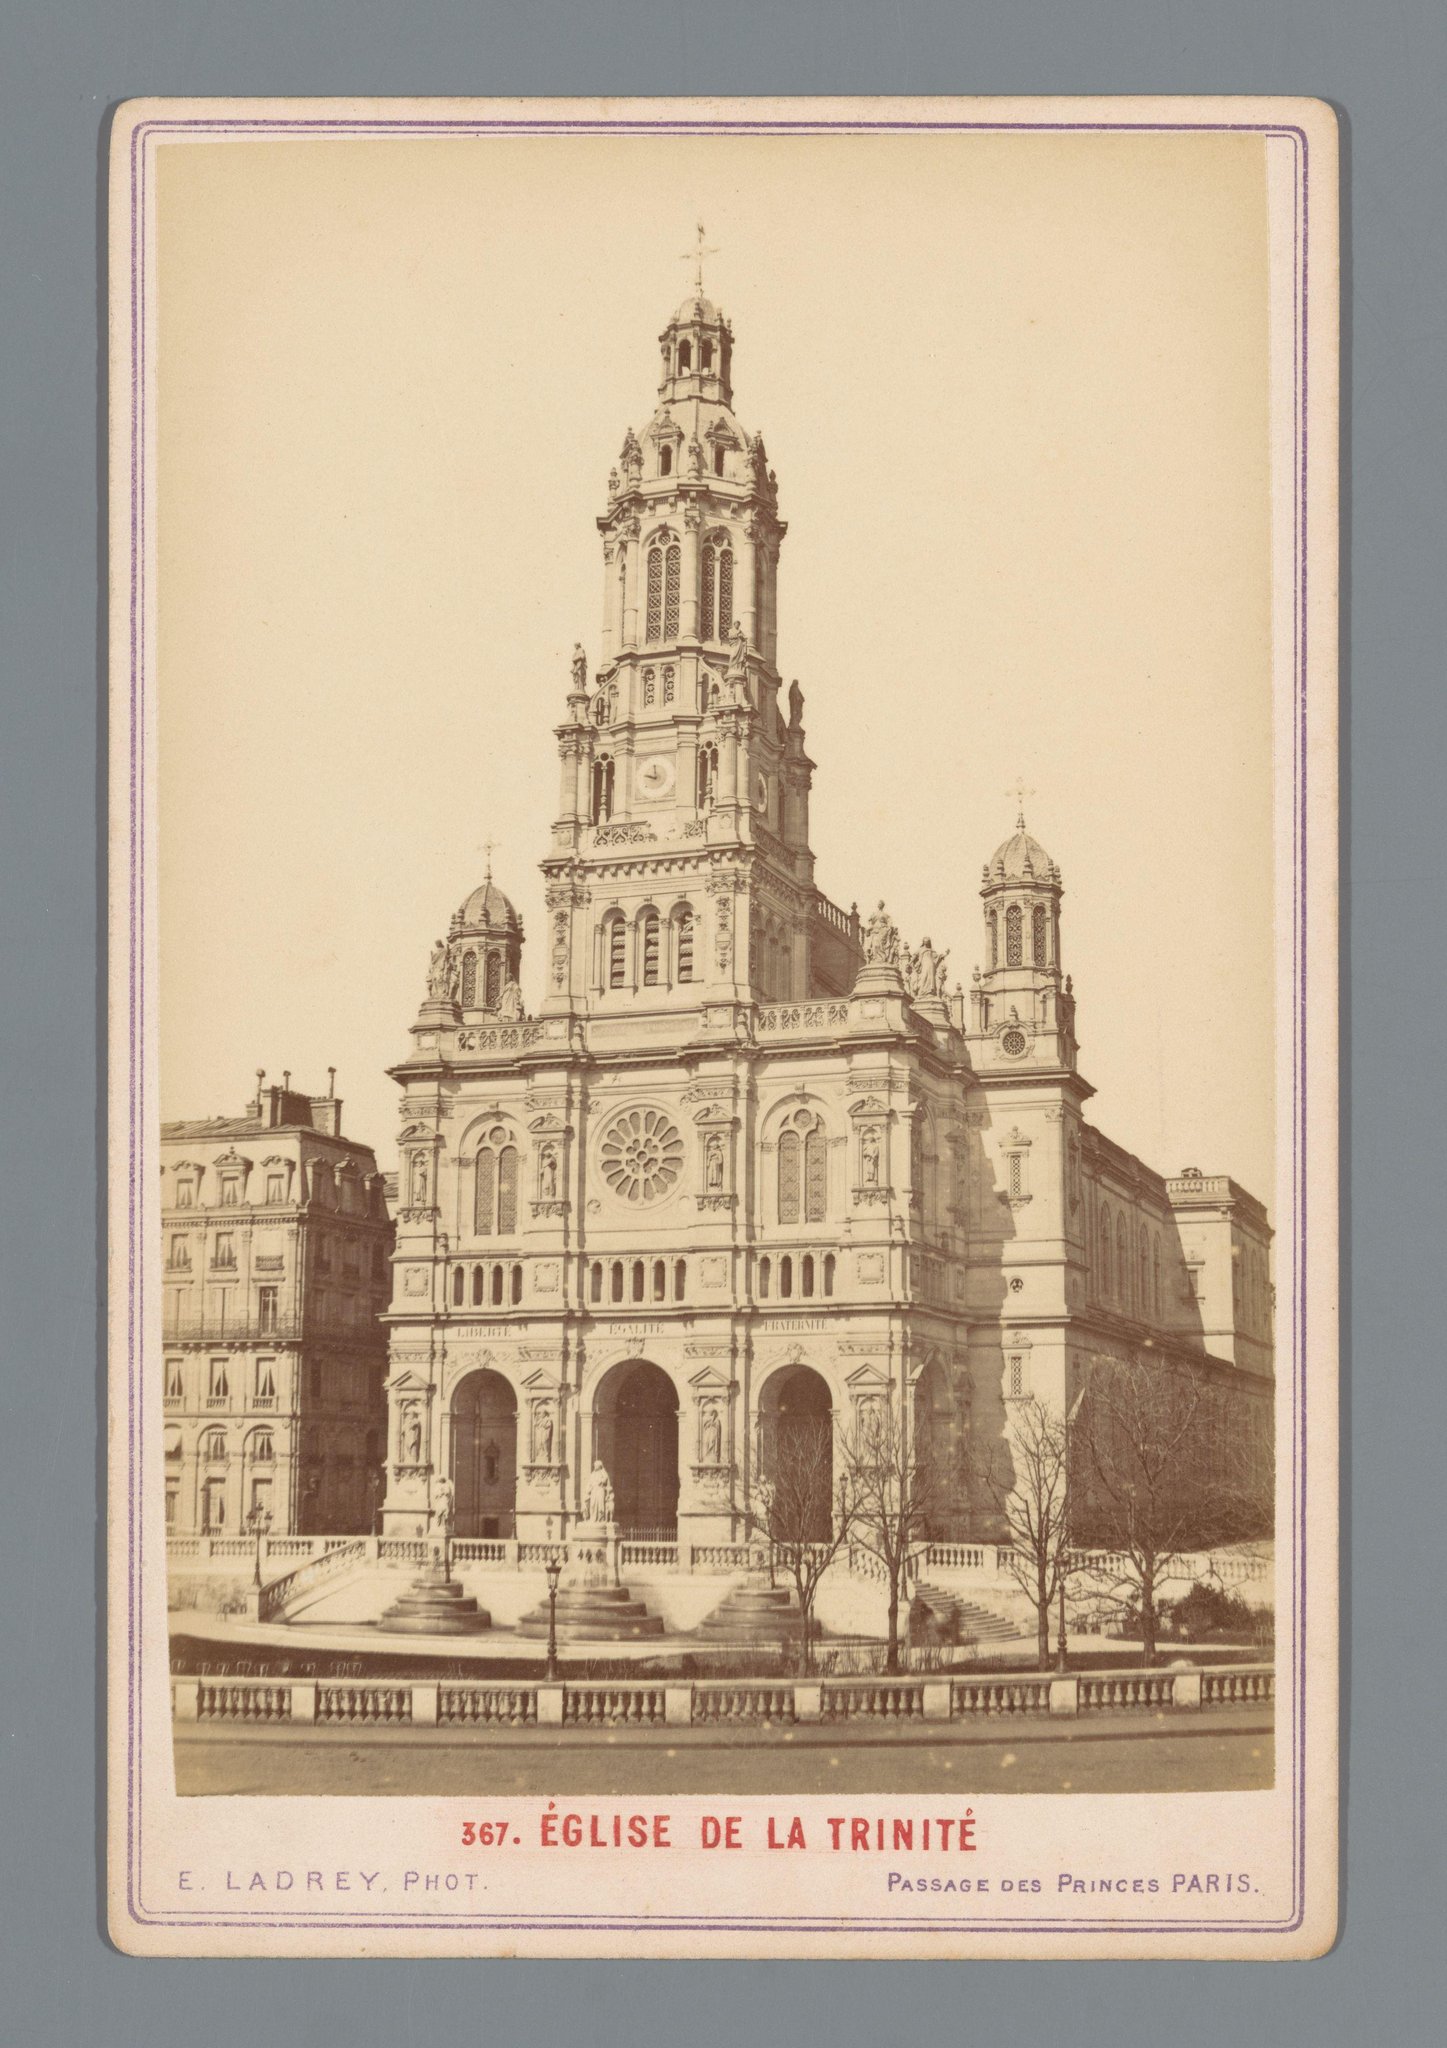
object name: photograph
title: Église de la Trinite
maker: ernest ladrey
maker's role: fotograaf, illustrator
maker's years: 1830-1889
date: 1860-1890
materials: cardboard, photographic support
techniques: albumen print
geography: paris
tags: church (exterior), façade (of house or building)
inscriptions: number: ‘367.’, address: ‘Passage des Princes PARIS.’, retailer's mark: ‘Maison Martinet/ 12, boulevard des capucines 12/ Grand-Hotel, Paris.’